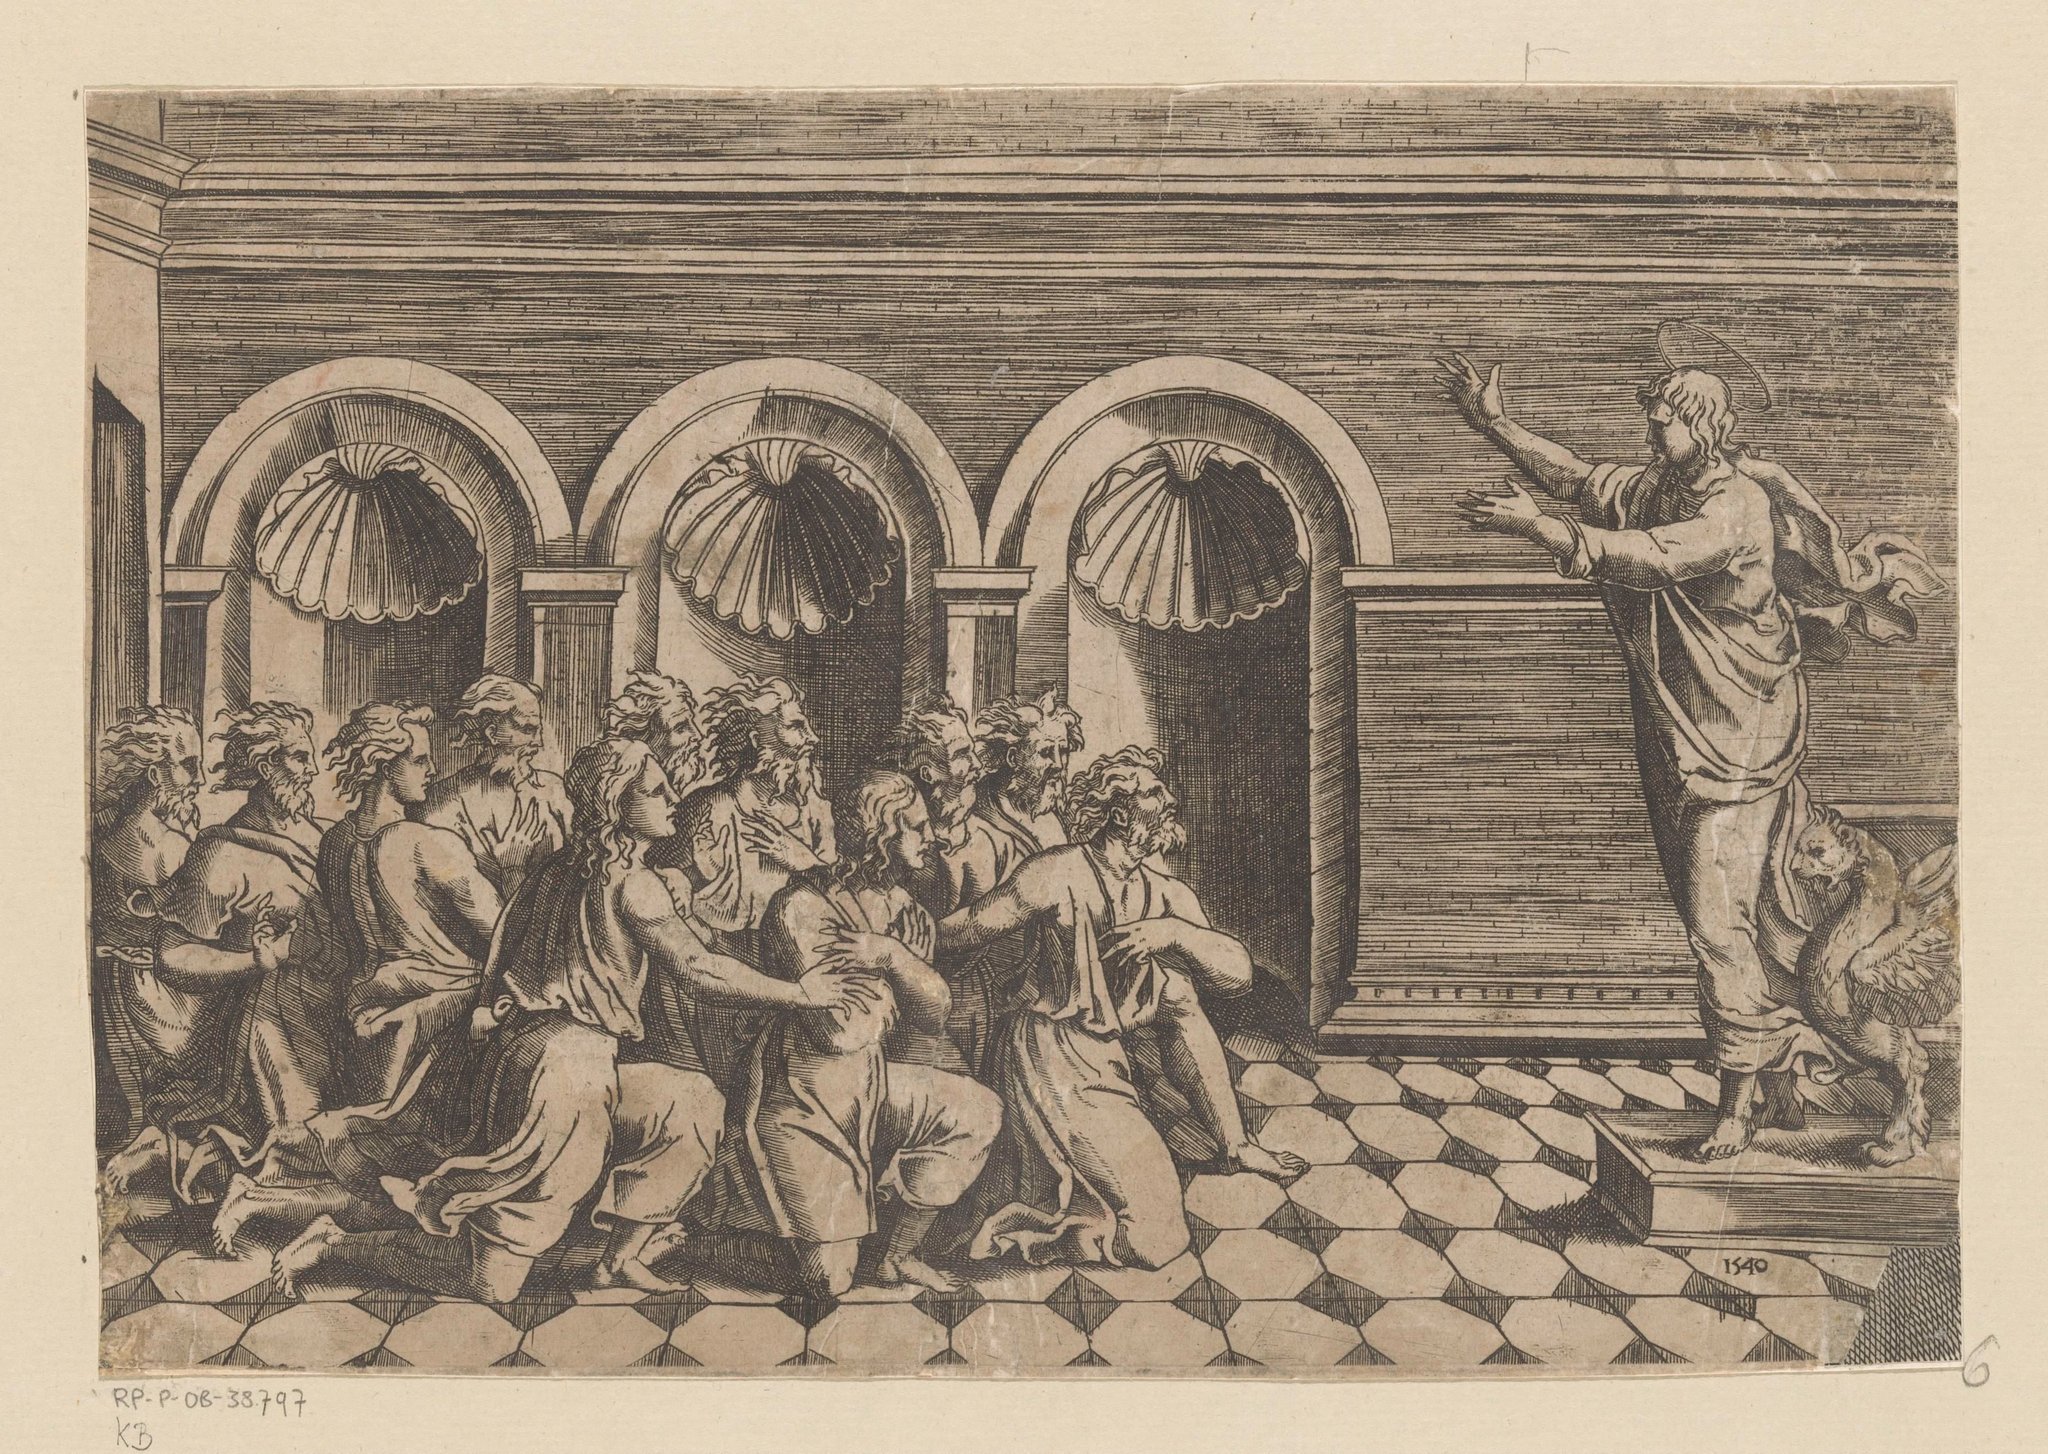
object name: print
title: Christus spreekt de apostelen toe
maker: Anonymous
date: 1540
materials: paper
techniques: engraving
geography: italy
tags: adult christ together with apostles, evangelists, saints, etc.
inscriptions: inscription: ‘f 220 : - : -’, collector's mark: Lugt 240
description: De prent is rechtsonder beschadigd en met een gedeelte van een andere prent aangevuld.